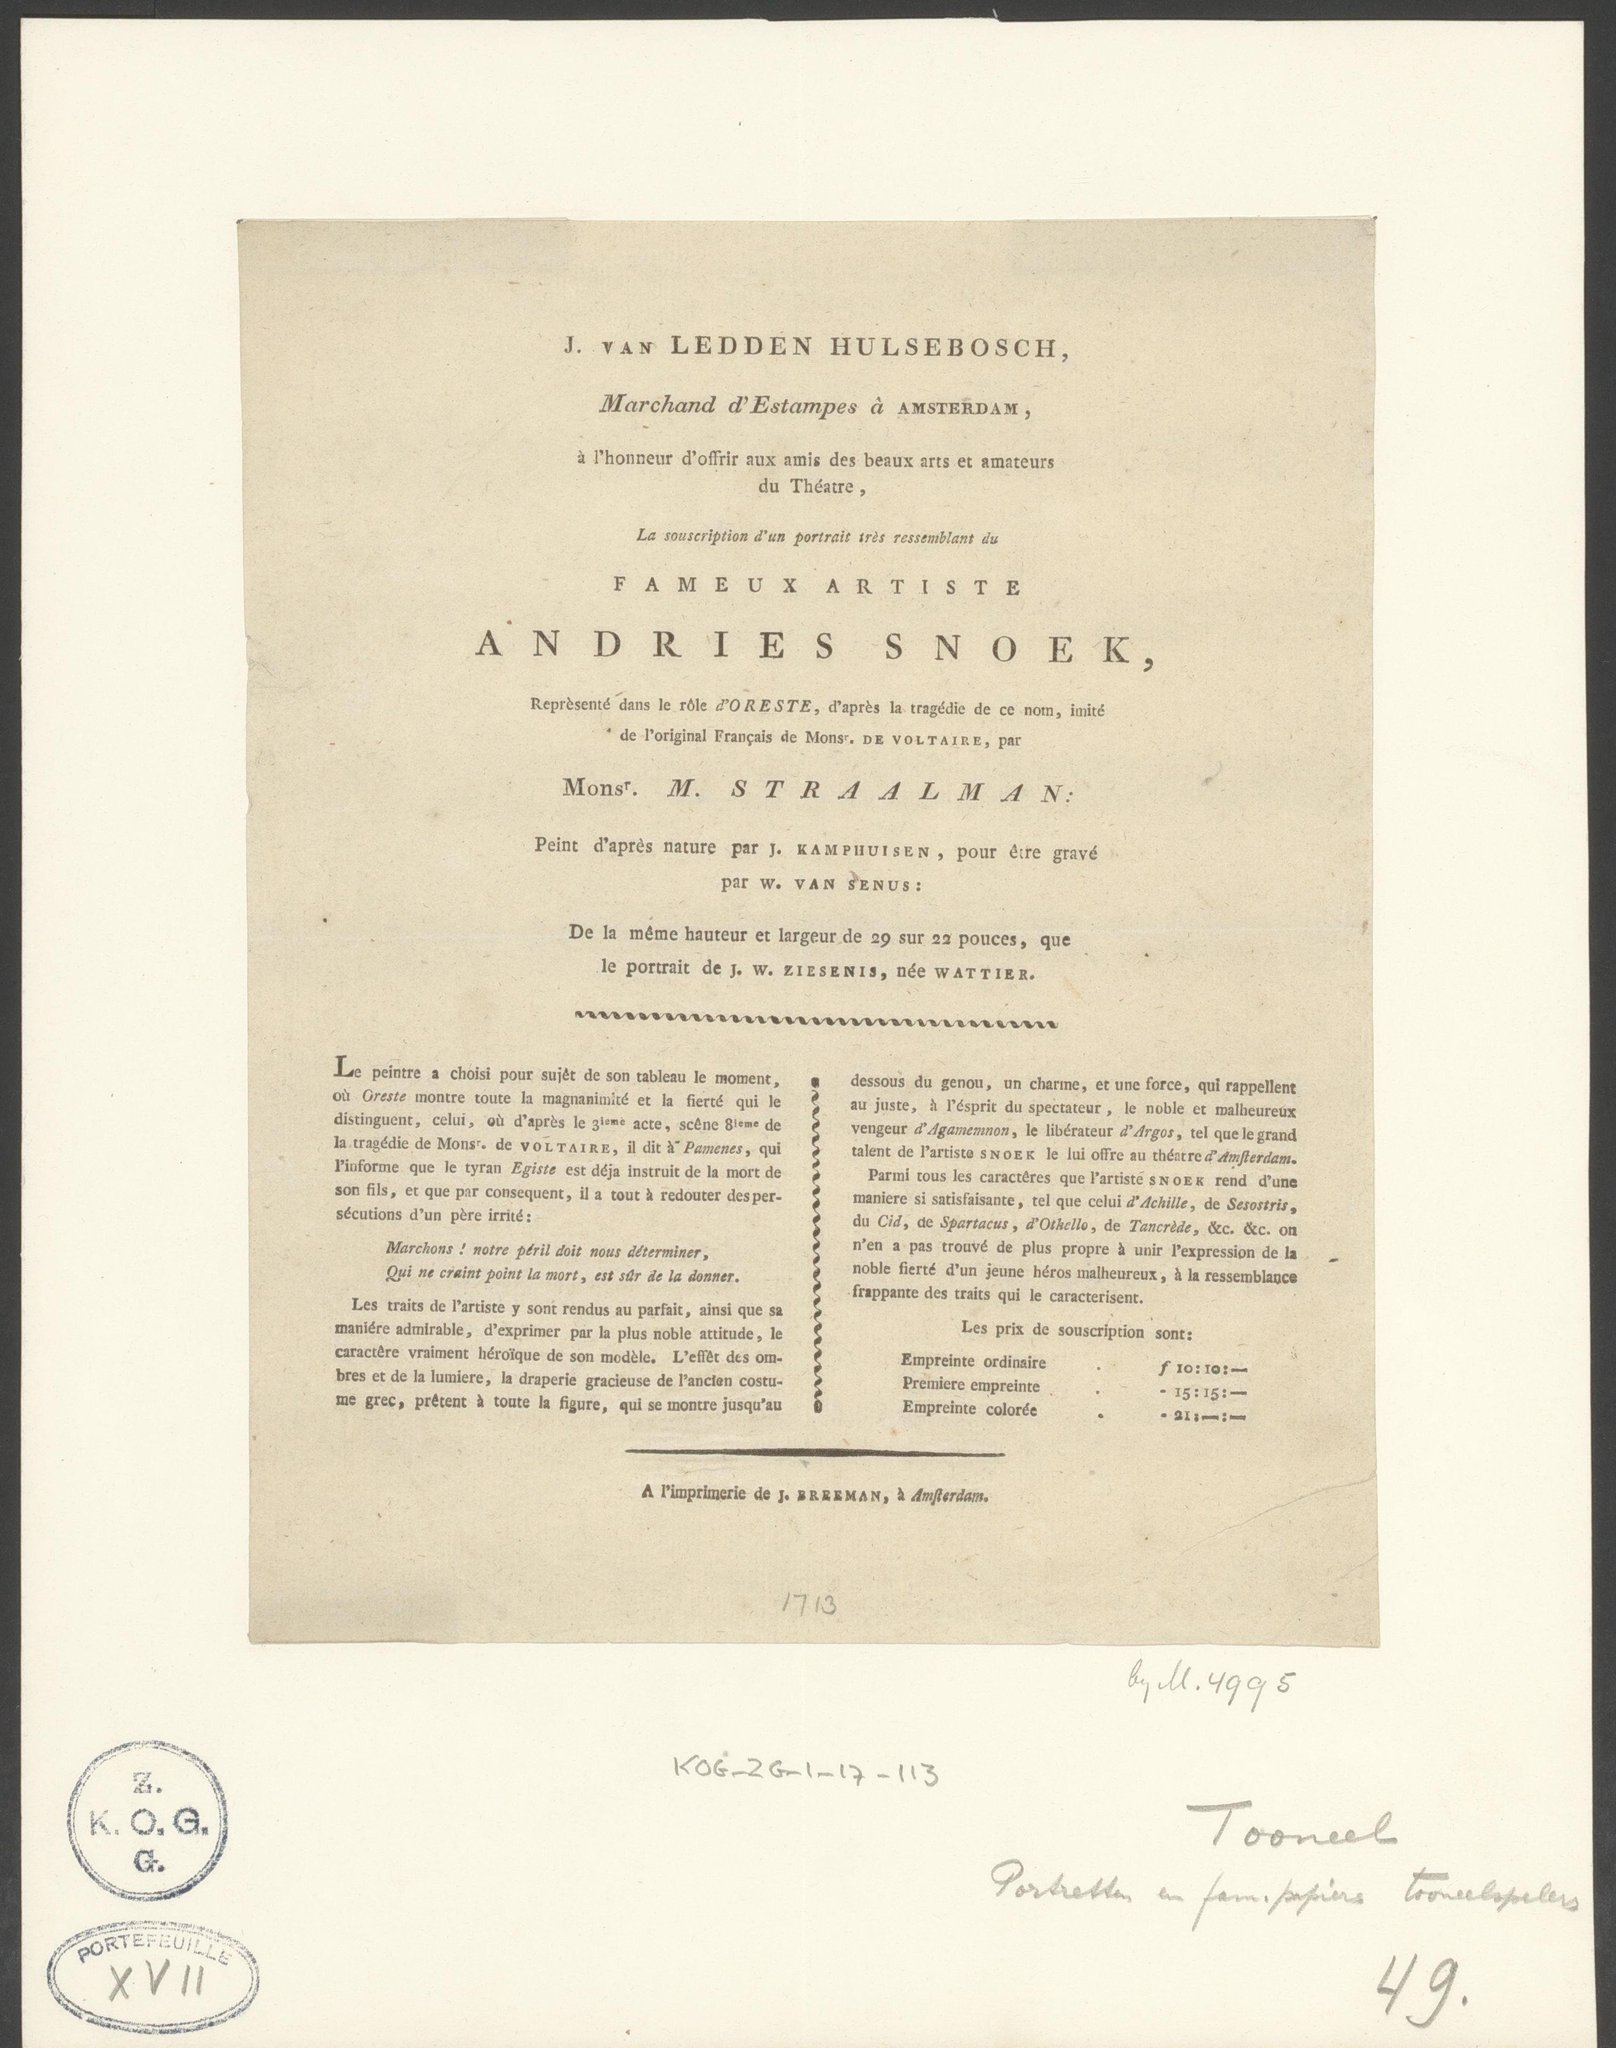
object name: text sheet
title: Advertentie voor een abonement op portretten van beroemde acteurs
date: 1803-1819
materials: paper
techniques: letterpress printing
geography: amsterdam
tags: amsterdam, the hague, mayor, matthys straalman, the arts of the stage: ballet, theatre, musical drama, motion picture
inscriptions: stamp, collector's mark: Lugt 1641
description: Advertentie voor een abonement op portretten van beroemde acteurs, zoals: Andreas Snoek en Matthys Straalman. Onderwerpsrubrieken binnen de Atlas Zeden en Gewoonten: Tooneel, Portretten van toneelspelers.